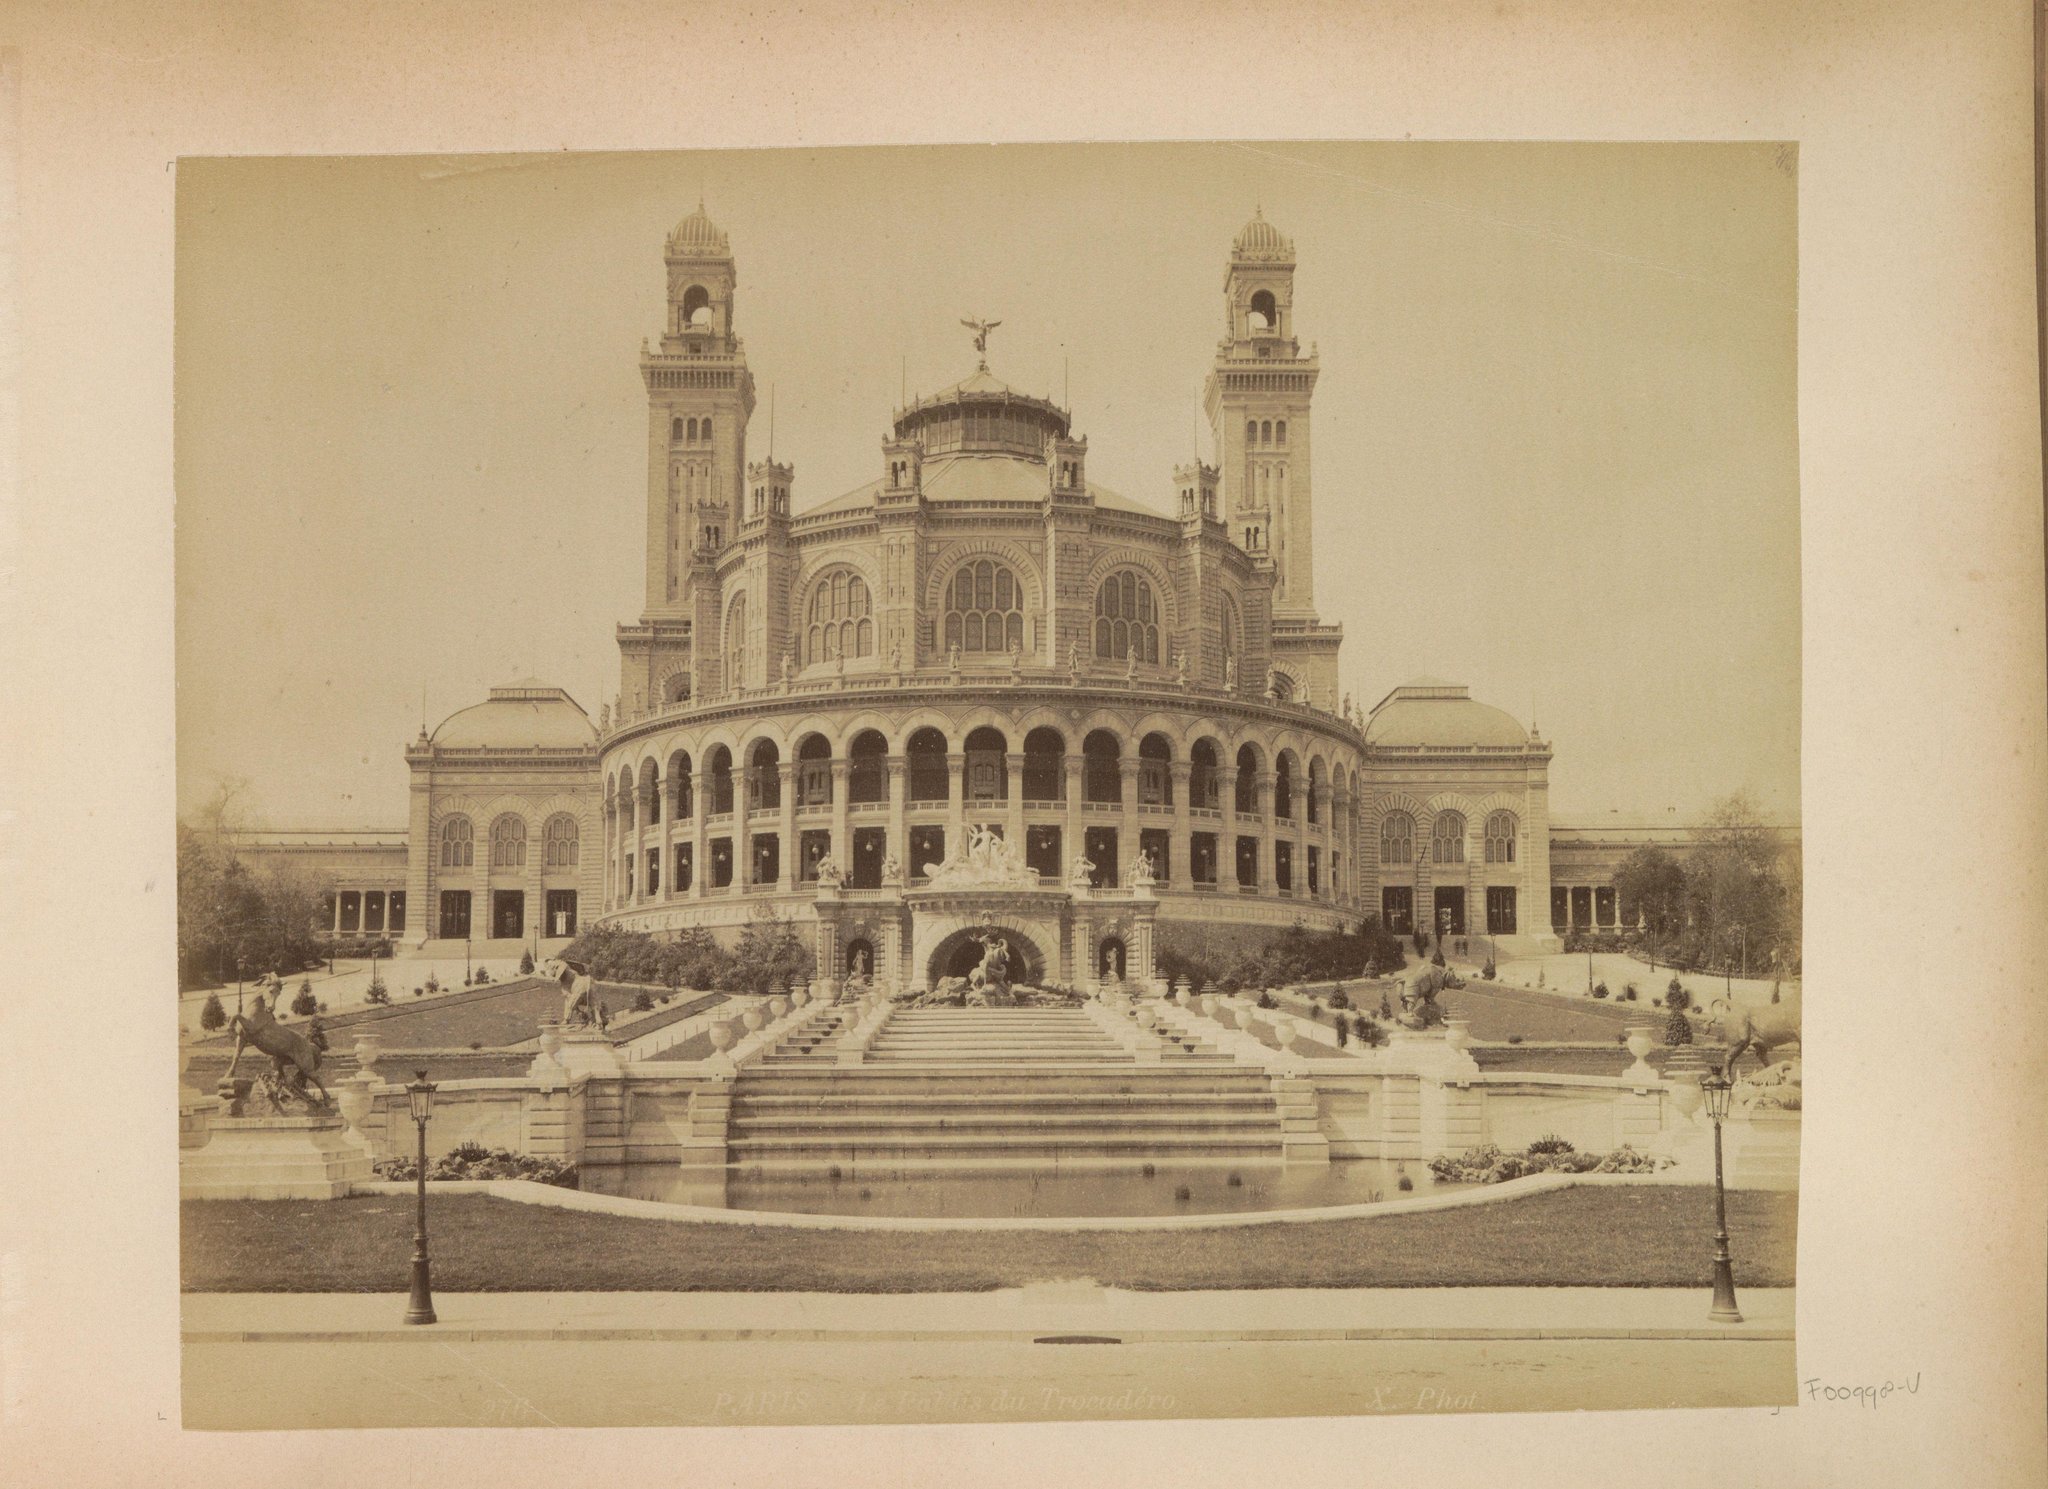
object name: photograph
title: Exterieur van het Palais du Trocadéro in Parijs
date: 1878-1895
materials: paper, photographic support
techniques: albumen print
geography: paris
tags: palace, paris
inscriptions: negative number: ‘276’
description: Onderdeel van Reisalbum met foto's van bezienswaardigheden in Frankrijk, Griekenland en Turkije.